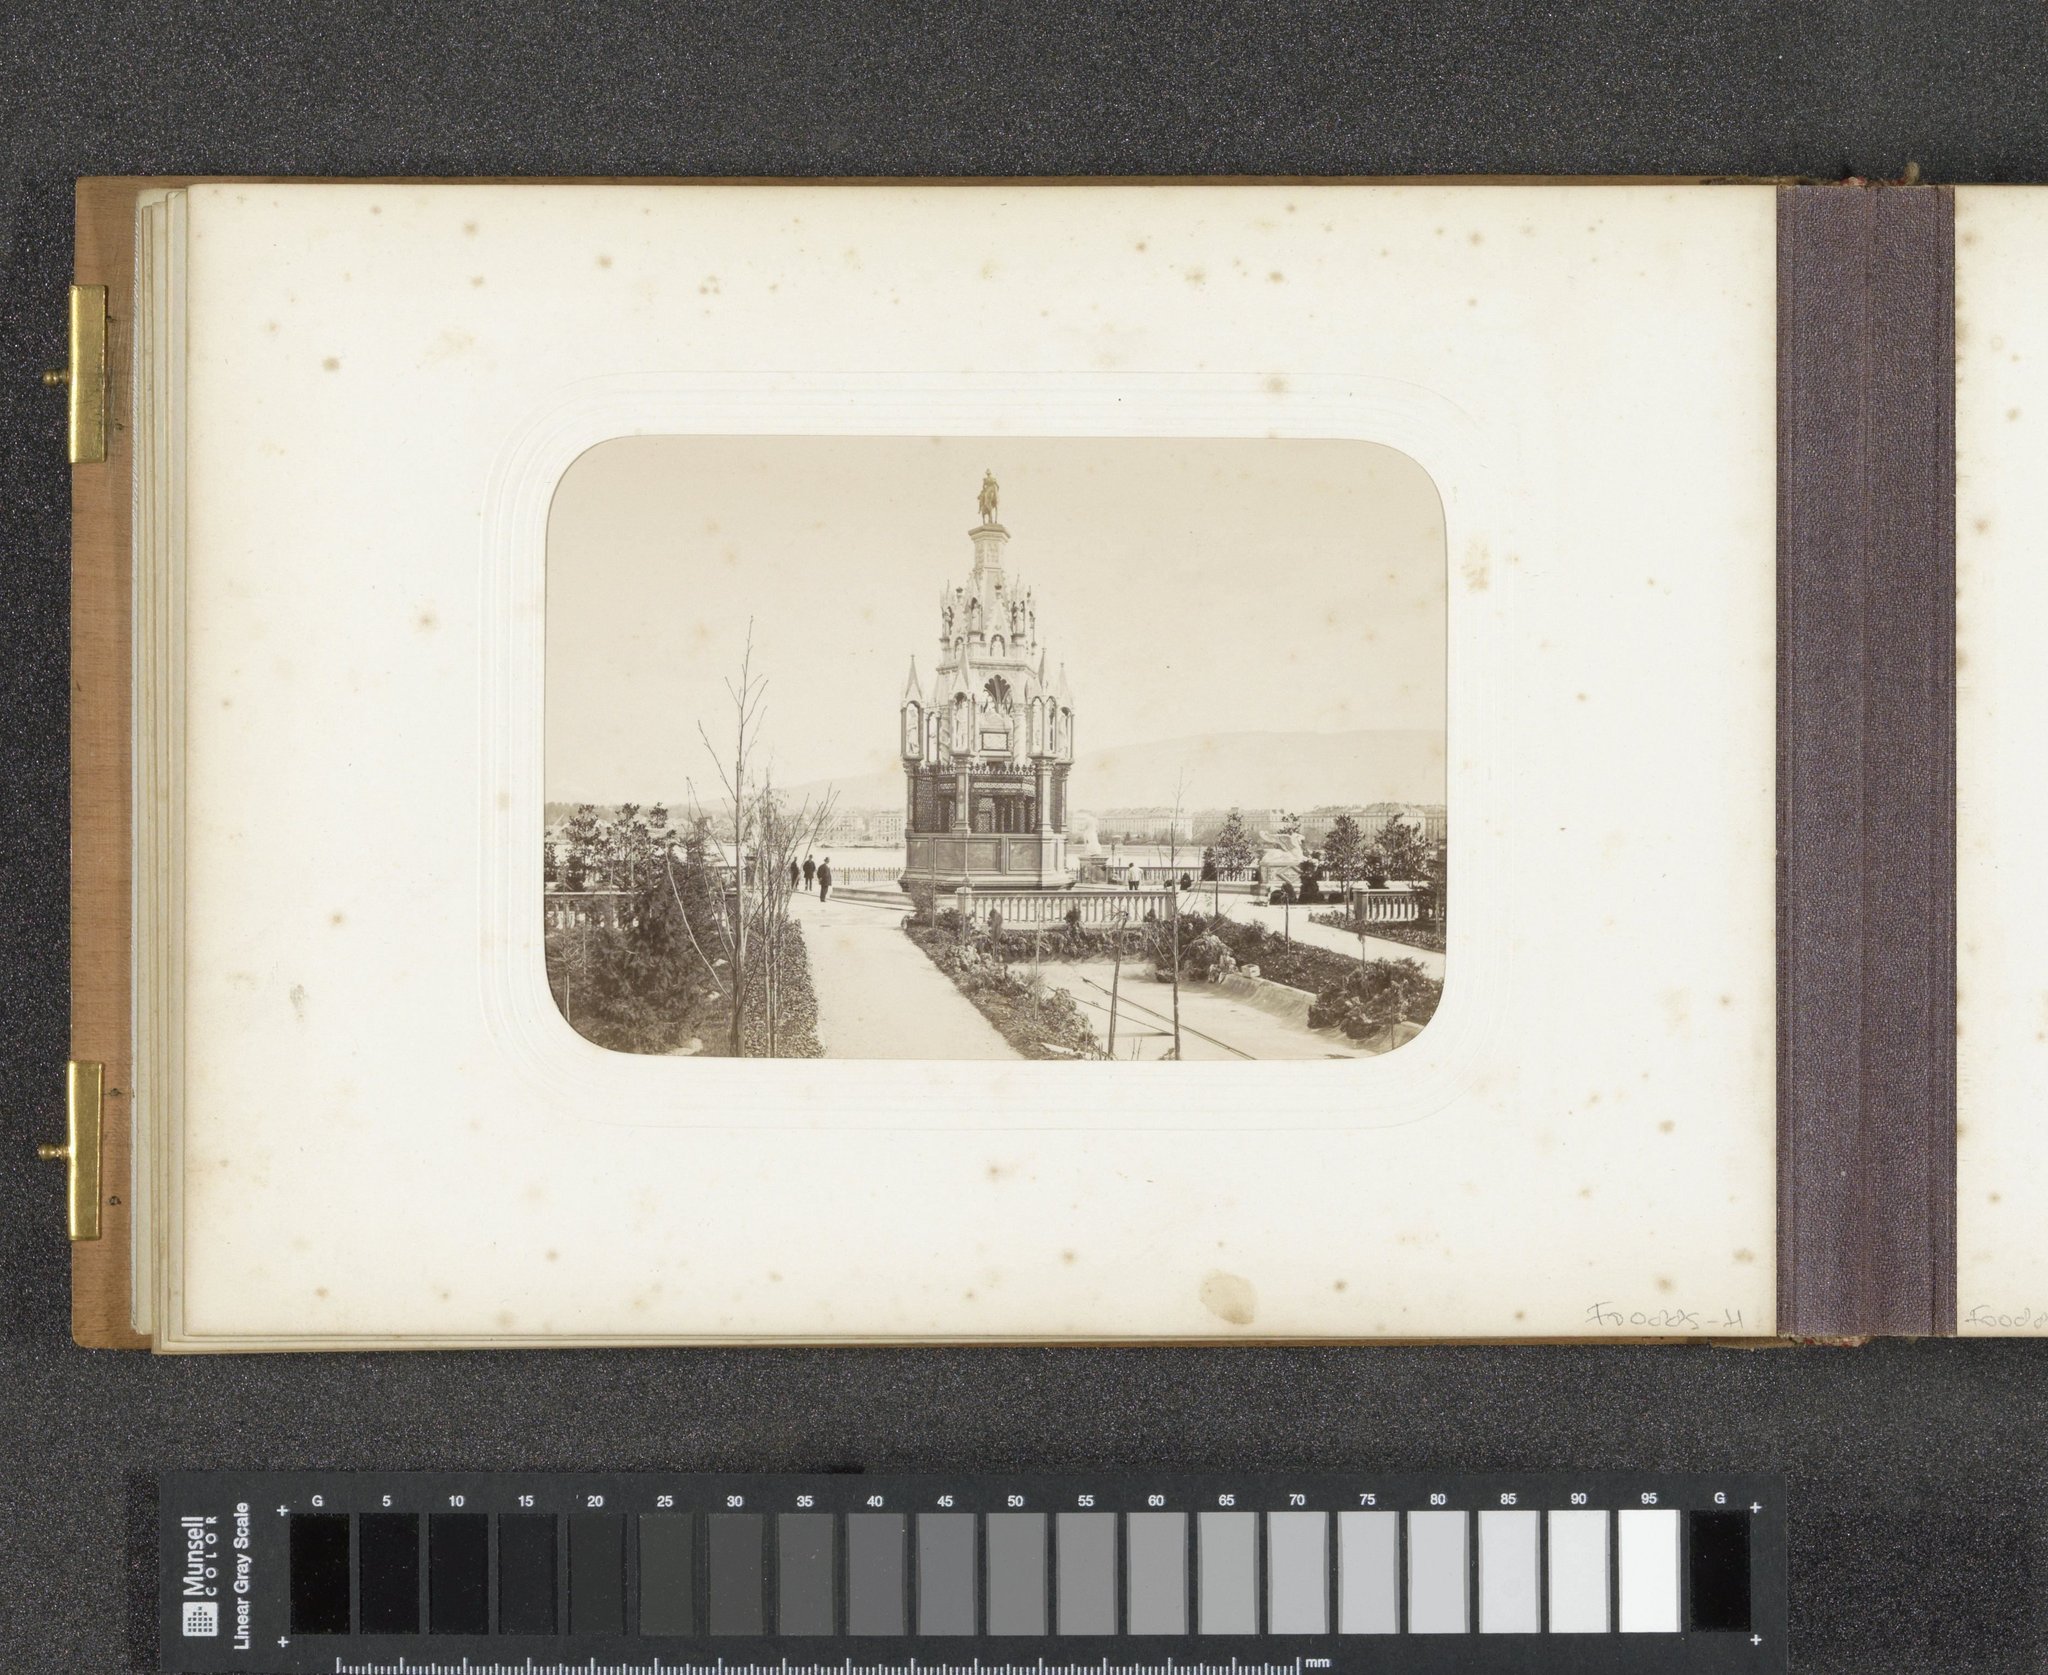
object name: cabinet photograph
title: Monument van de Hertog van Brunswijk in Genève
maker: auguste garcin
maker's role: fotograaf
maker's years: 1816-1895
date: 1860-1880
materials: cardboard, paper, photographic support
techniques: albumen print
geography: geneva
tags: monument, statue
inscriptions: number: ‘713’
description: Onderdeel van Reisalbum met bezienswaardigheden in de Zwitserse Alpen.